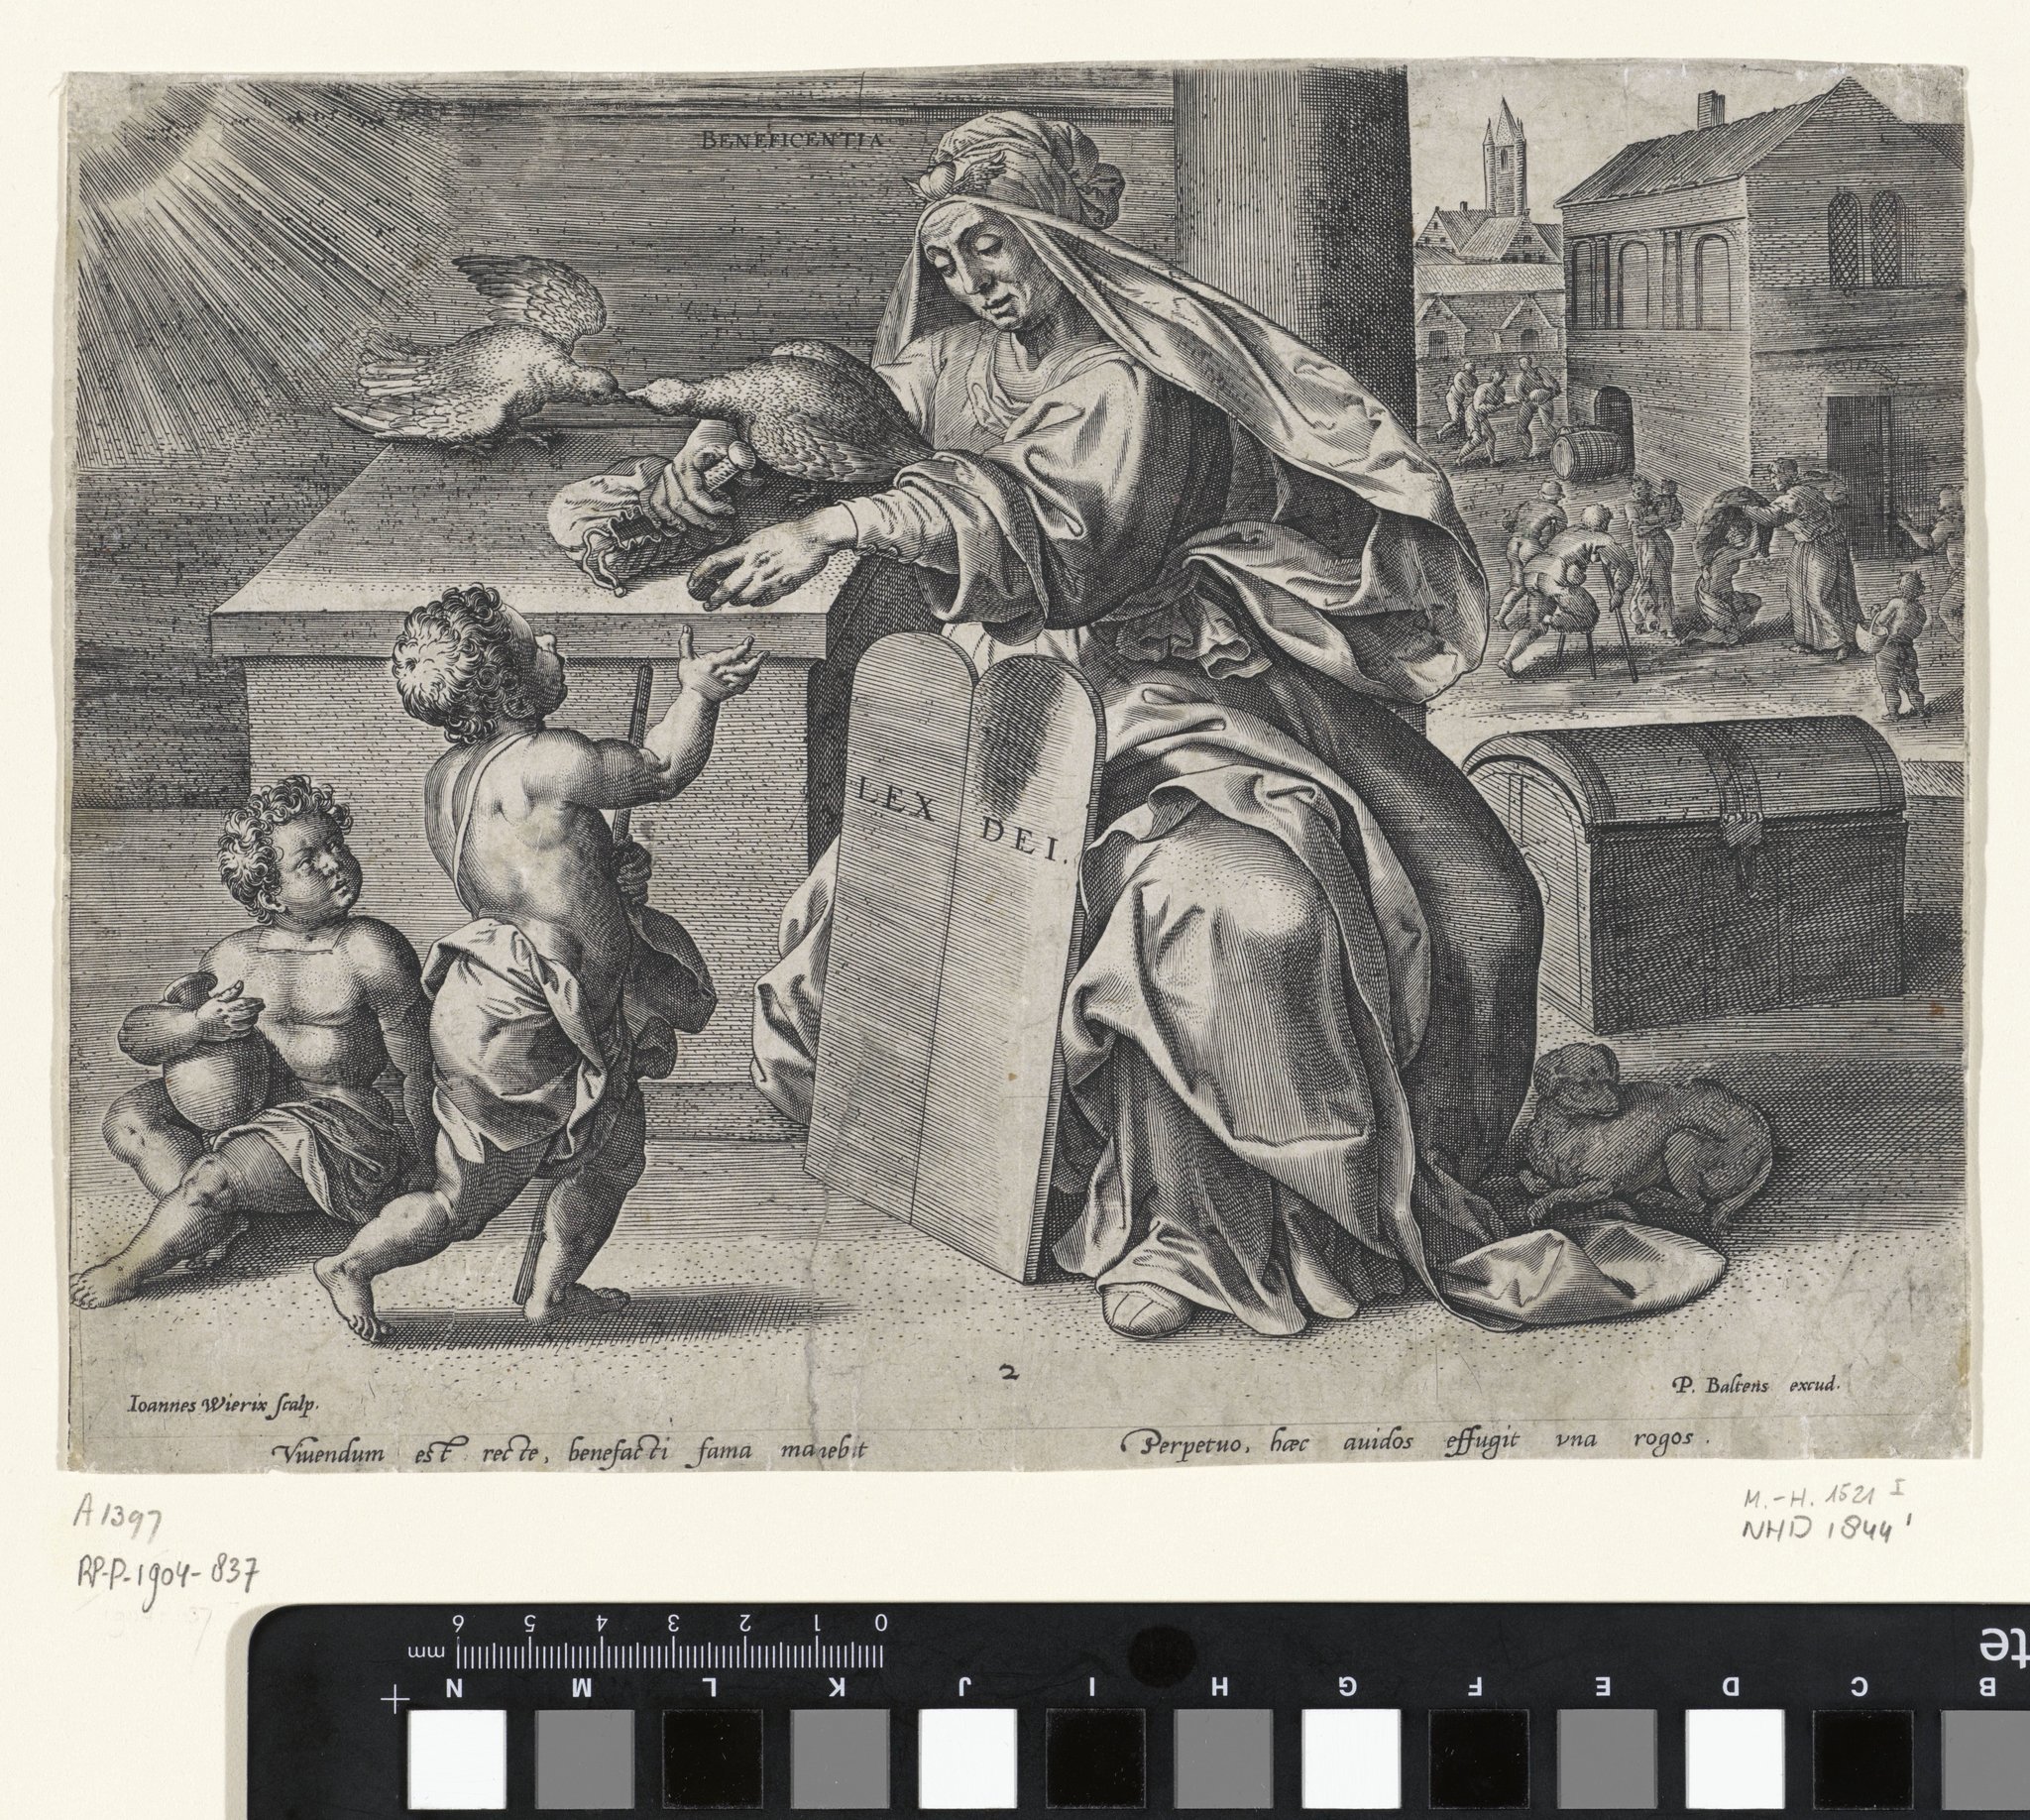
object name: print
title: De drie door de mens begeerde gunsten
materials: paper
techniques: engraving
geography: antwerp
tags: benevolence, beneficence; 'beneficio', 'benevolenza o affettione' (ripa), symbols of christ ~ animals, charitable works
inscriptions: collector's mark: Lugt 2228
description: De vrouwelijke personificatie van Genade (Beneficentia) overhandigt geld aan twee kinderen. In haar hand de geopende stokkenbeurs. Aan haar voeten ligt een hondje. Tegen haar benen staan de tafelen der wet. Naast haar op een altaar voedt een pelikaan haar jong. Rechts op de achtergrond werken van barmhartigheid afgebeeld. In de marge een onderschrift in het Latijn.